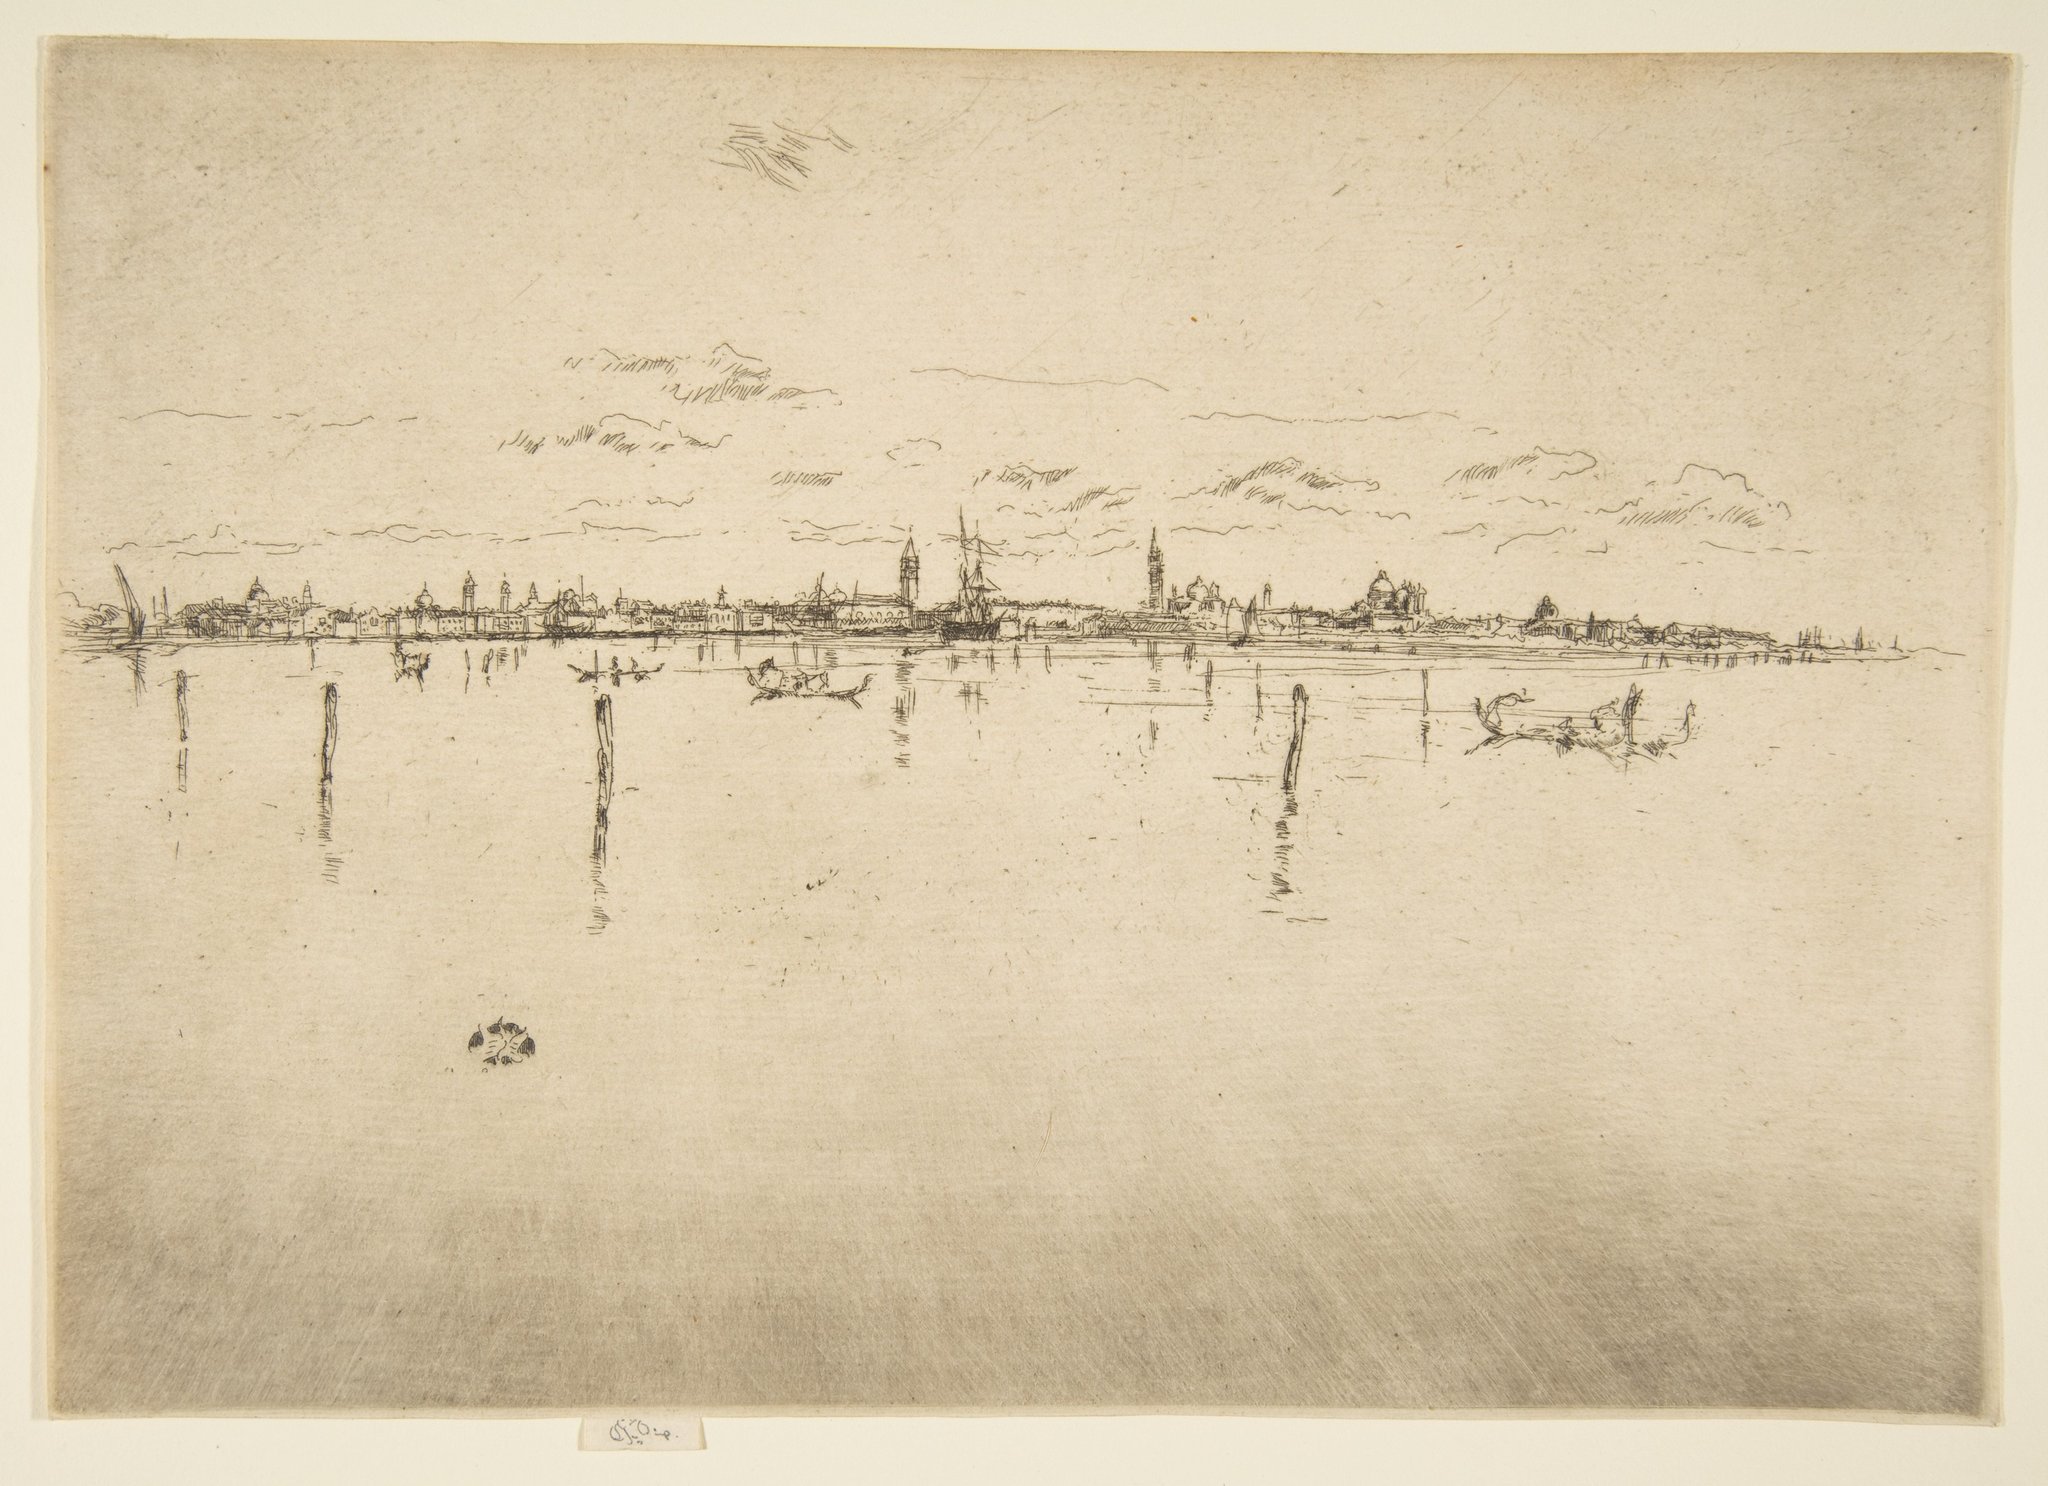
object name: print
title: Little Venice (The Little Venice)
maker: james mcneill whistler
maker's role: artist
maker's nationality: american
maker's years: 1834-1903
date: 1879-1880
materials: ink, paper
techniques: etching, printing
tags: boats,venice